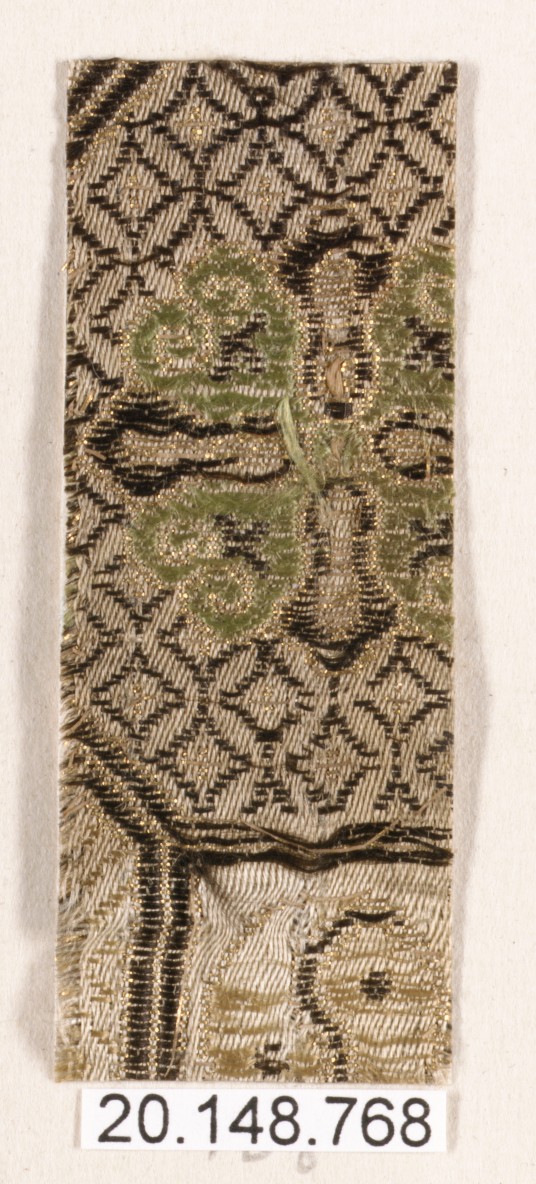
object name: piece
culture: japanese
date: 1601-1700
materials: silk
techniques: compound weave